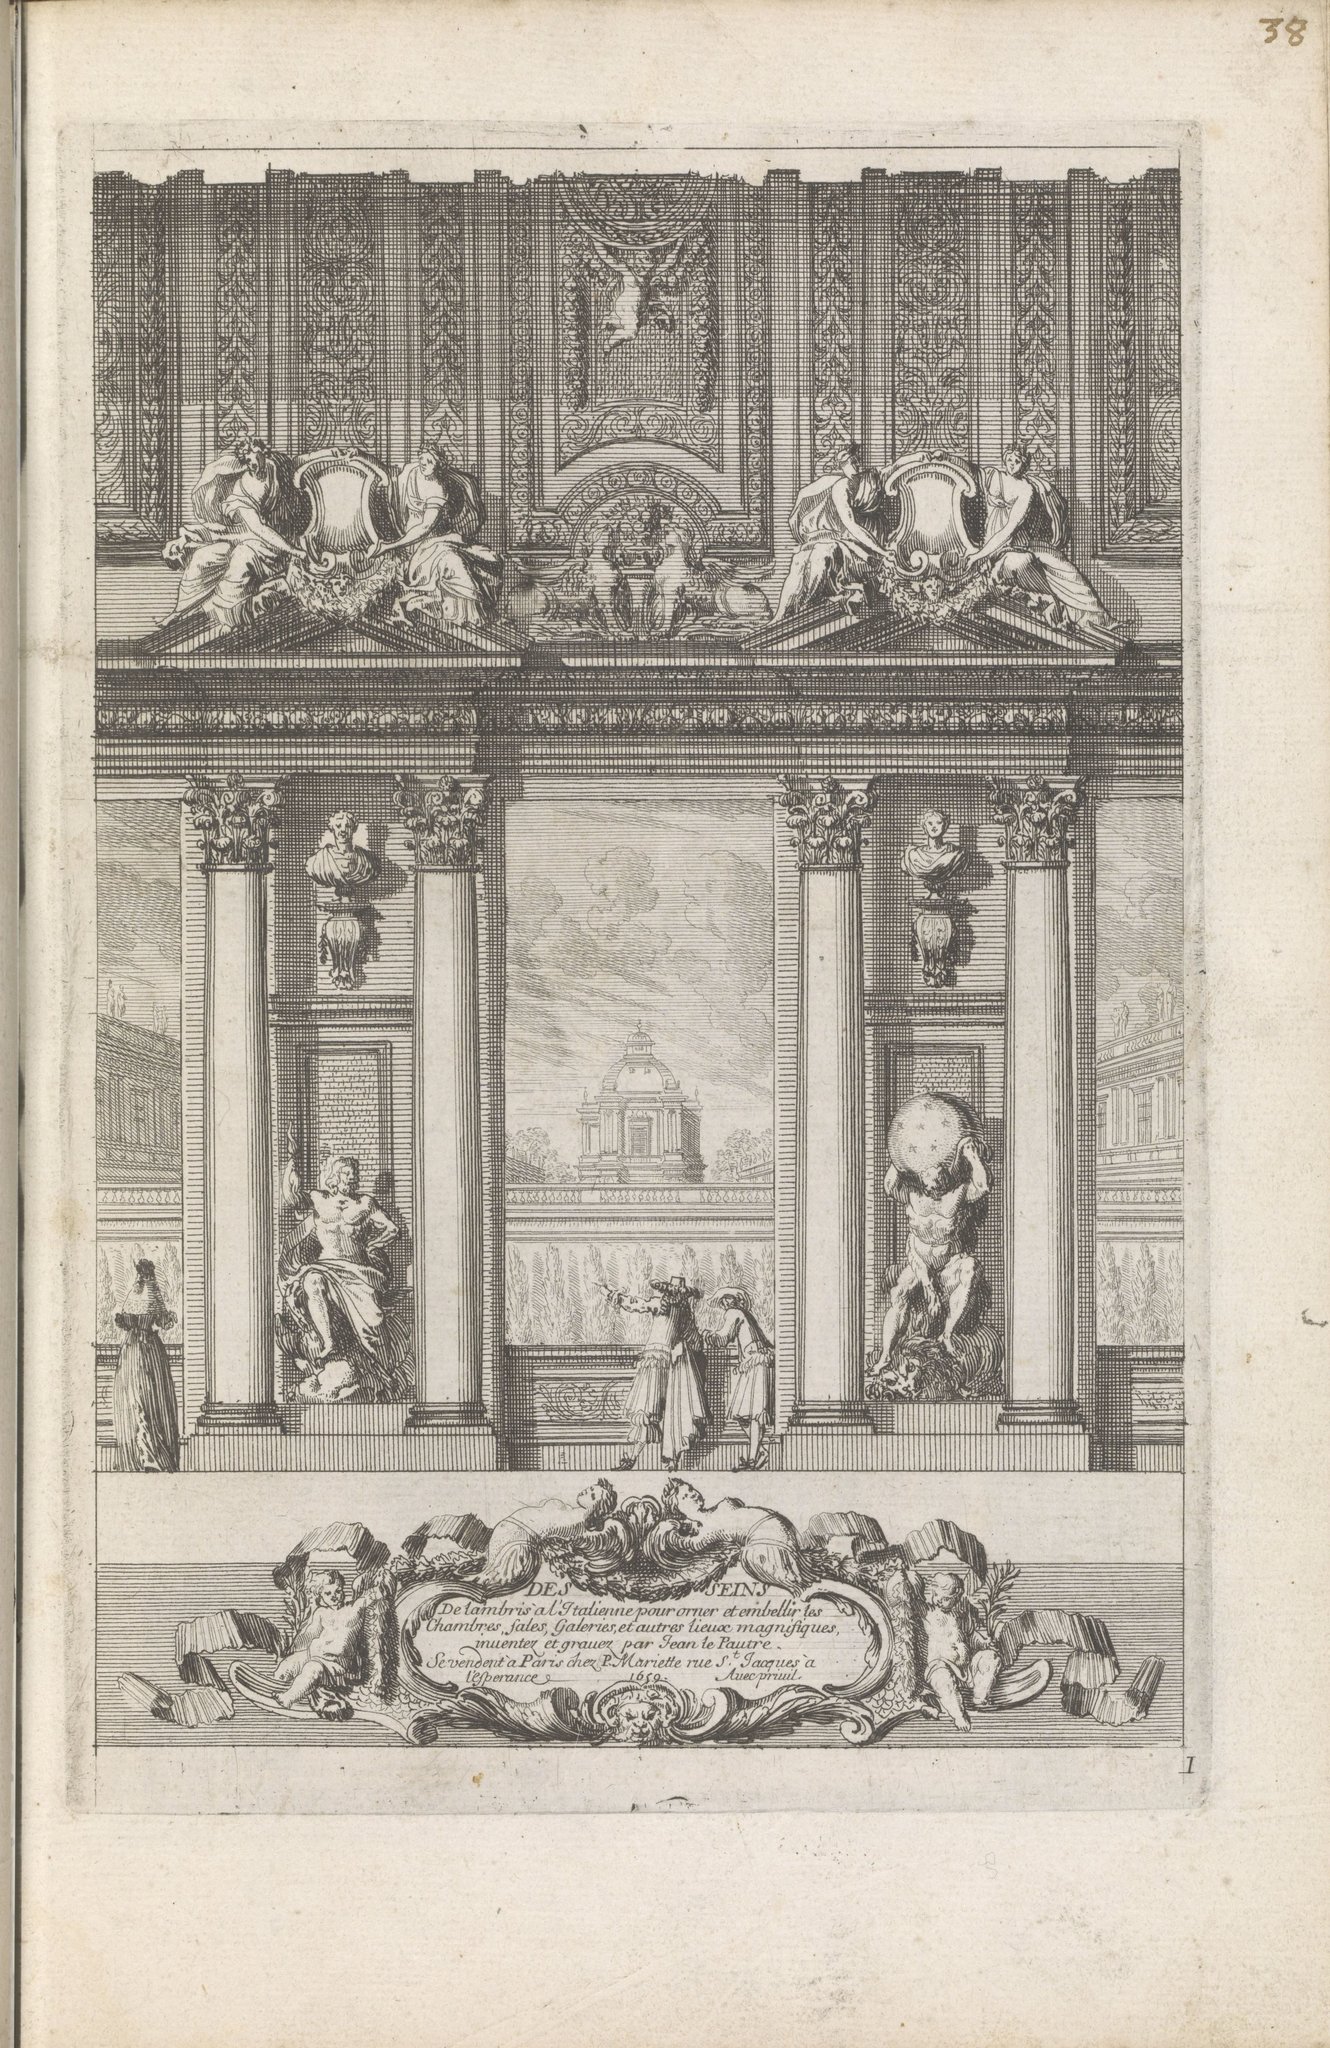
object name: titelprent, frontispice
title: Galerij van een paleis met daarachter een tuin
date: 1659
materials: paper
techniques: etching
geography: paris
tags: ornaments ~ art, panelling, gallery (spacious corridor)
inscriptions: date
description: Galerij van een paleis met daarachter een tuin. Links een standbeeld van Jupiter en rechts een standbeeld van Hercules. Prent maakt deel uit van een album.